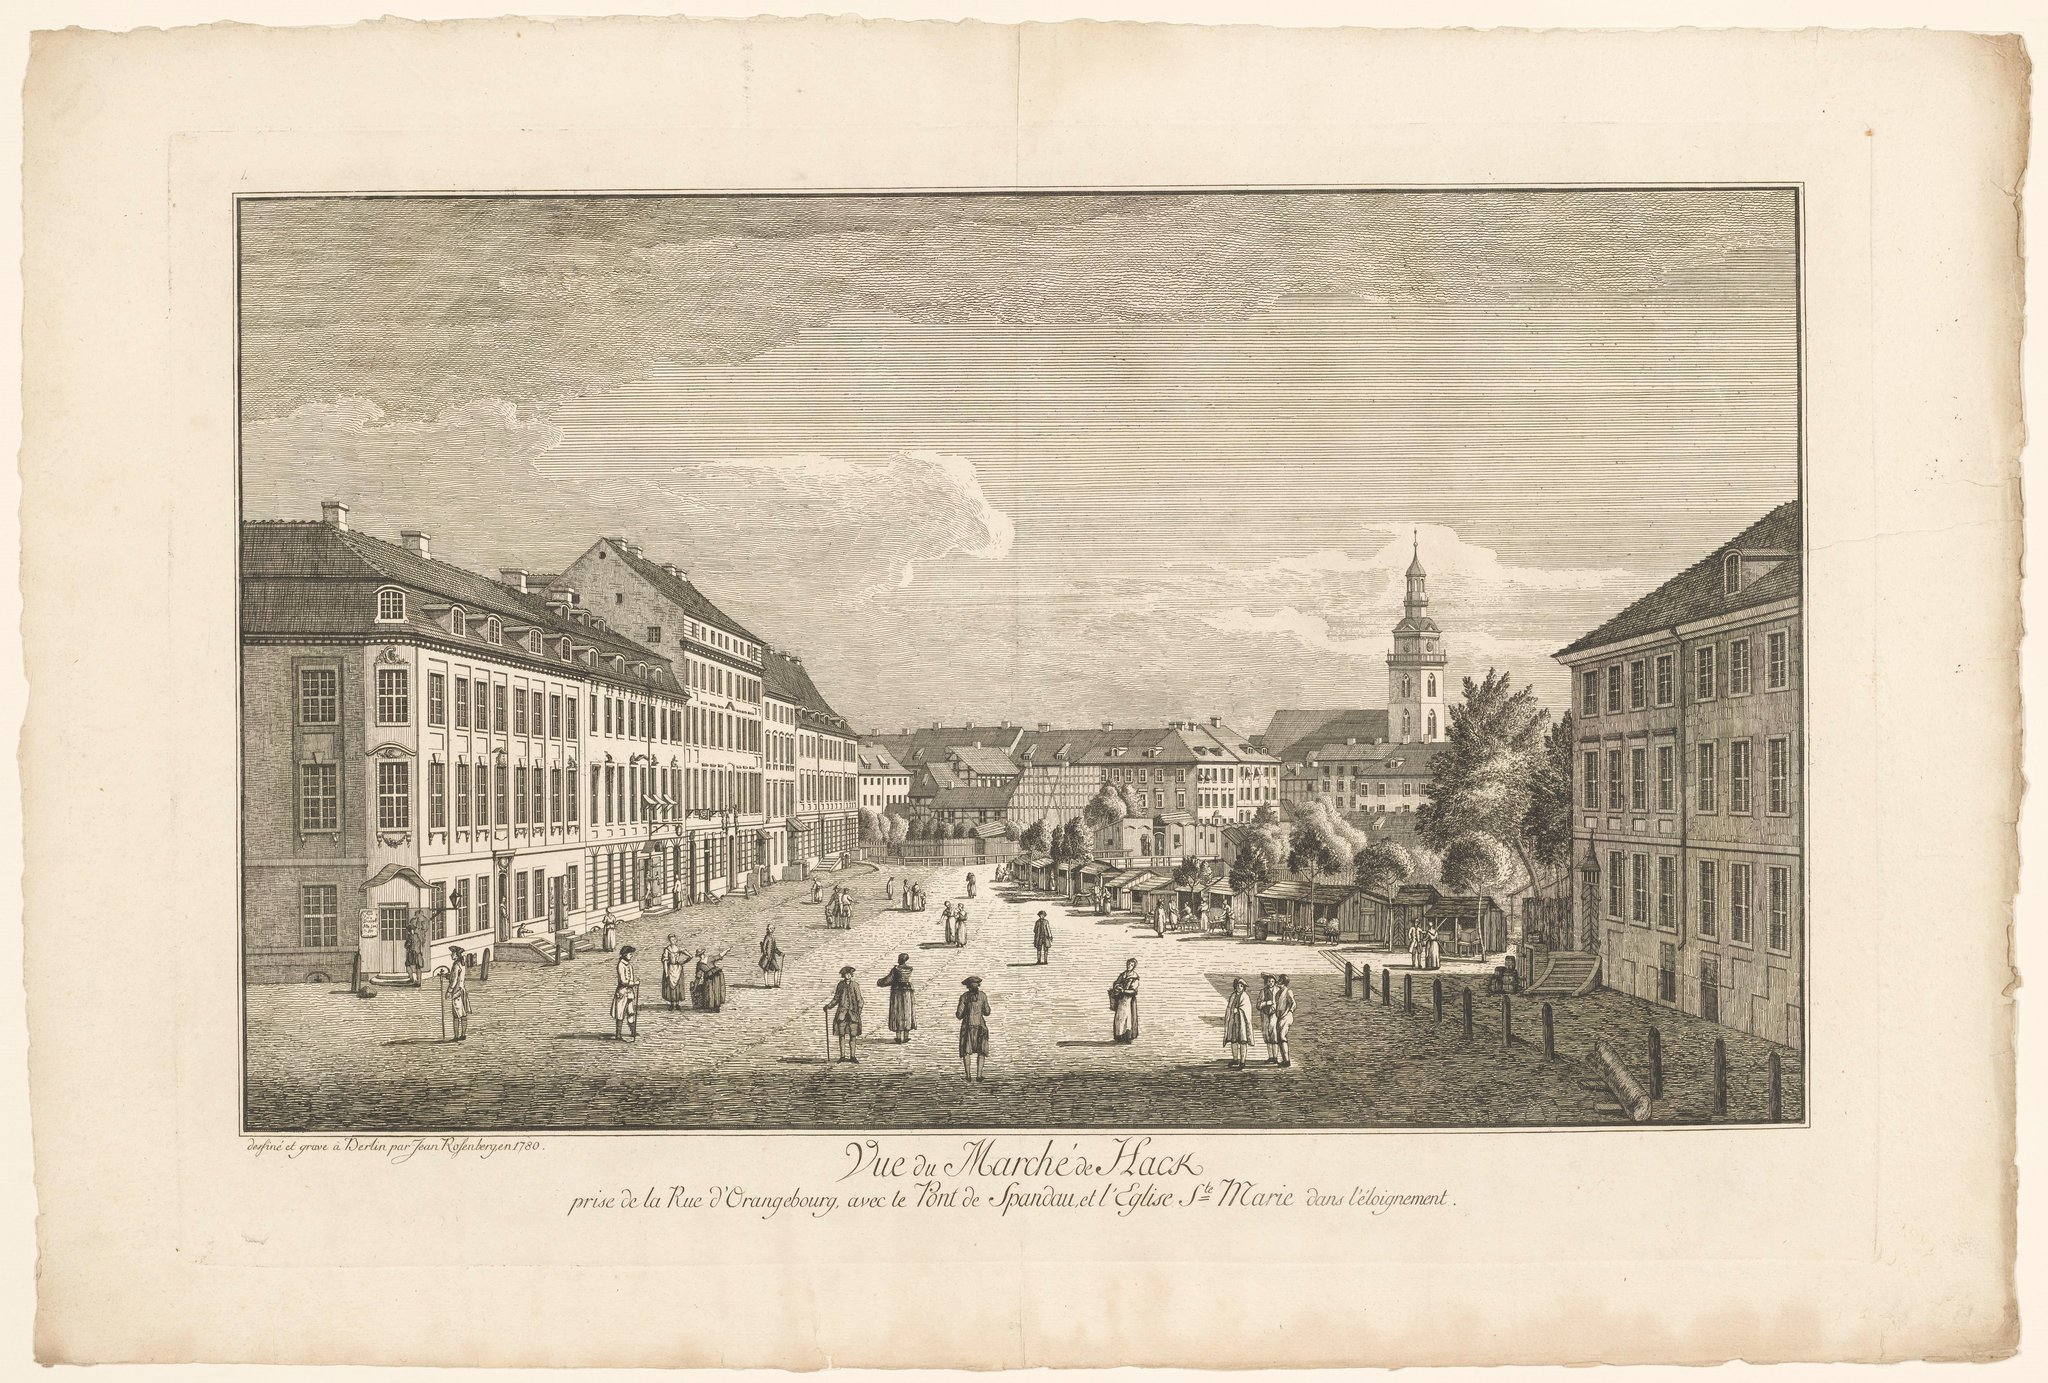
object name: print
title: Gezicht op de Hackescher Markt in Berlijn, met de Marienkirche op de achtergrond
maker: johann georg rosenberg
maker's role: print maker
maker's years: 1739-1808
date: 1780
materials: paper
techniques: engraving, etching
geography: berlin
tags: square, place, circus, etc., church (exterior), market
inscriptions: collector's mark: Lugt 2228